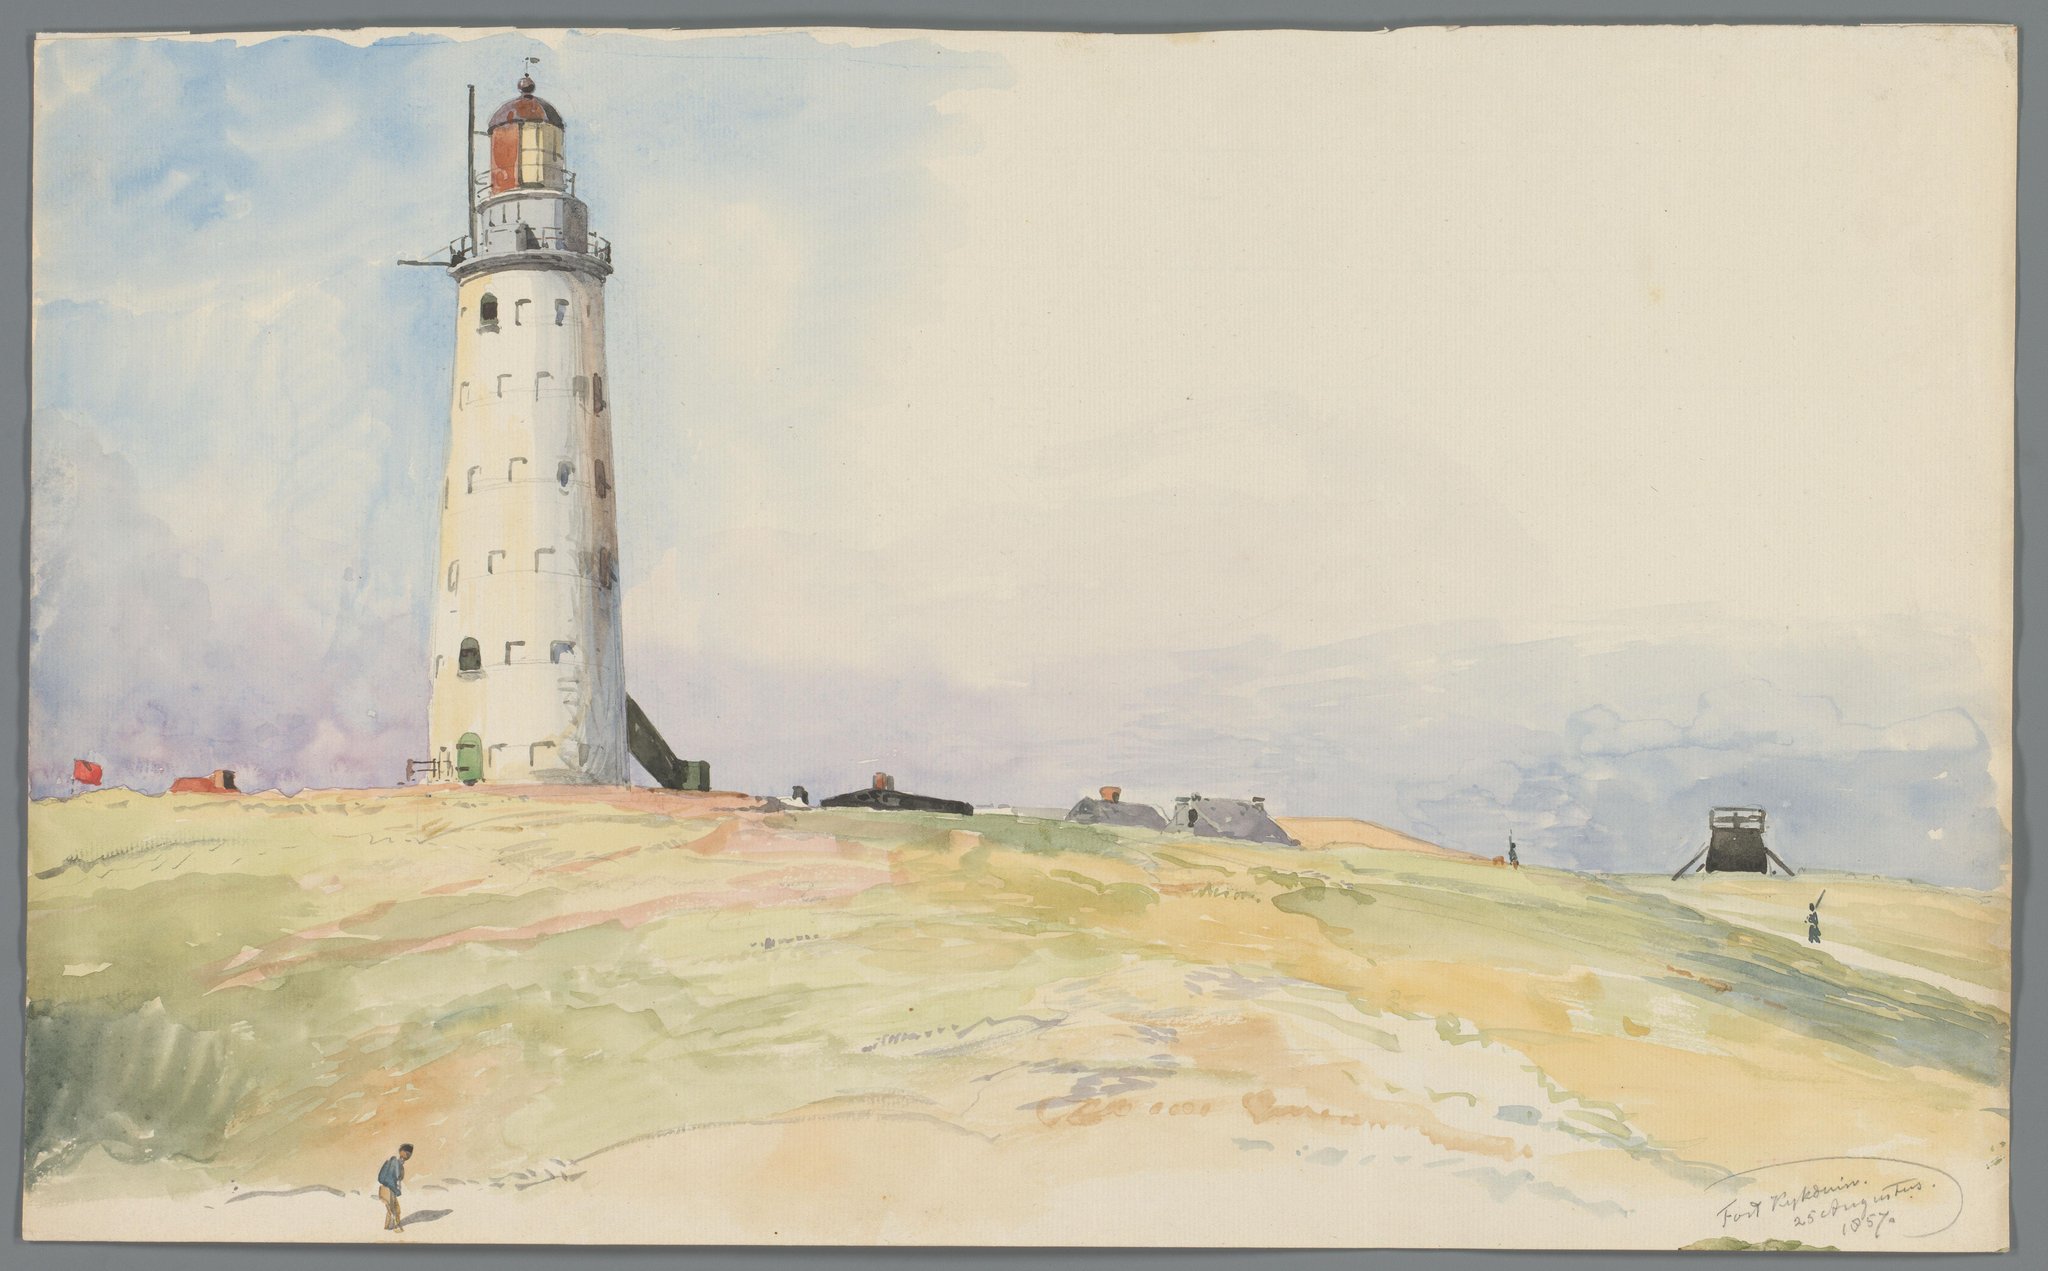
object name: drawing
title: De vuurtoren te Kijkduin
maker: willem anthonie van deventer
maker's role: draughtsman, painter, print maker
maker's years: 1824-1893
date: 1857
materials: paper, pencil, watercolor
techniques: brush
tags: lighthouse, lightship